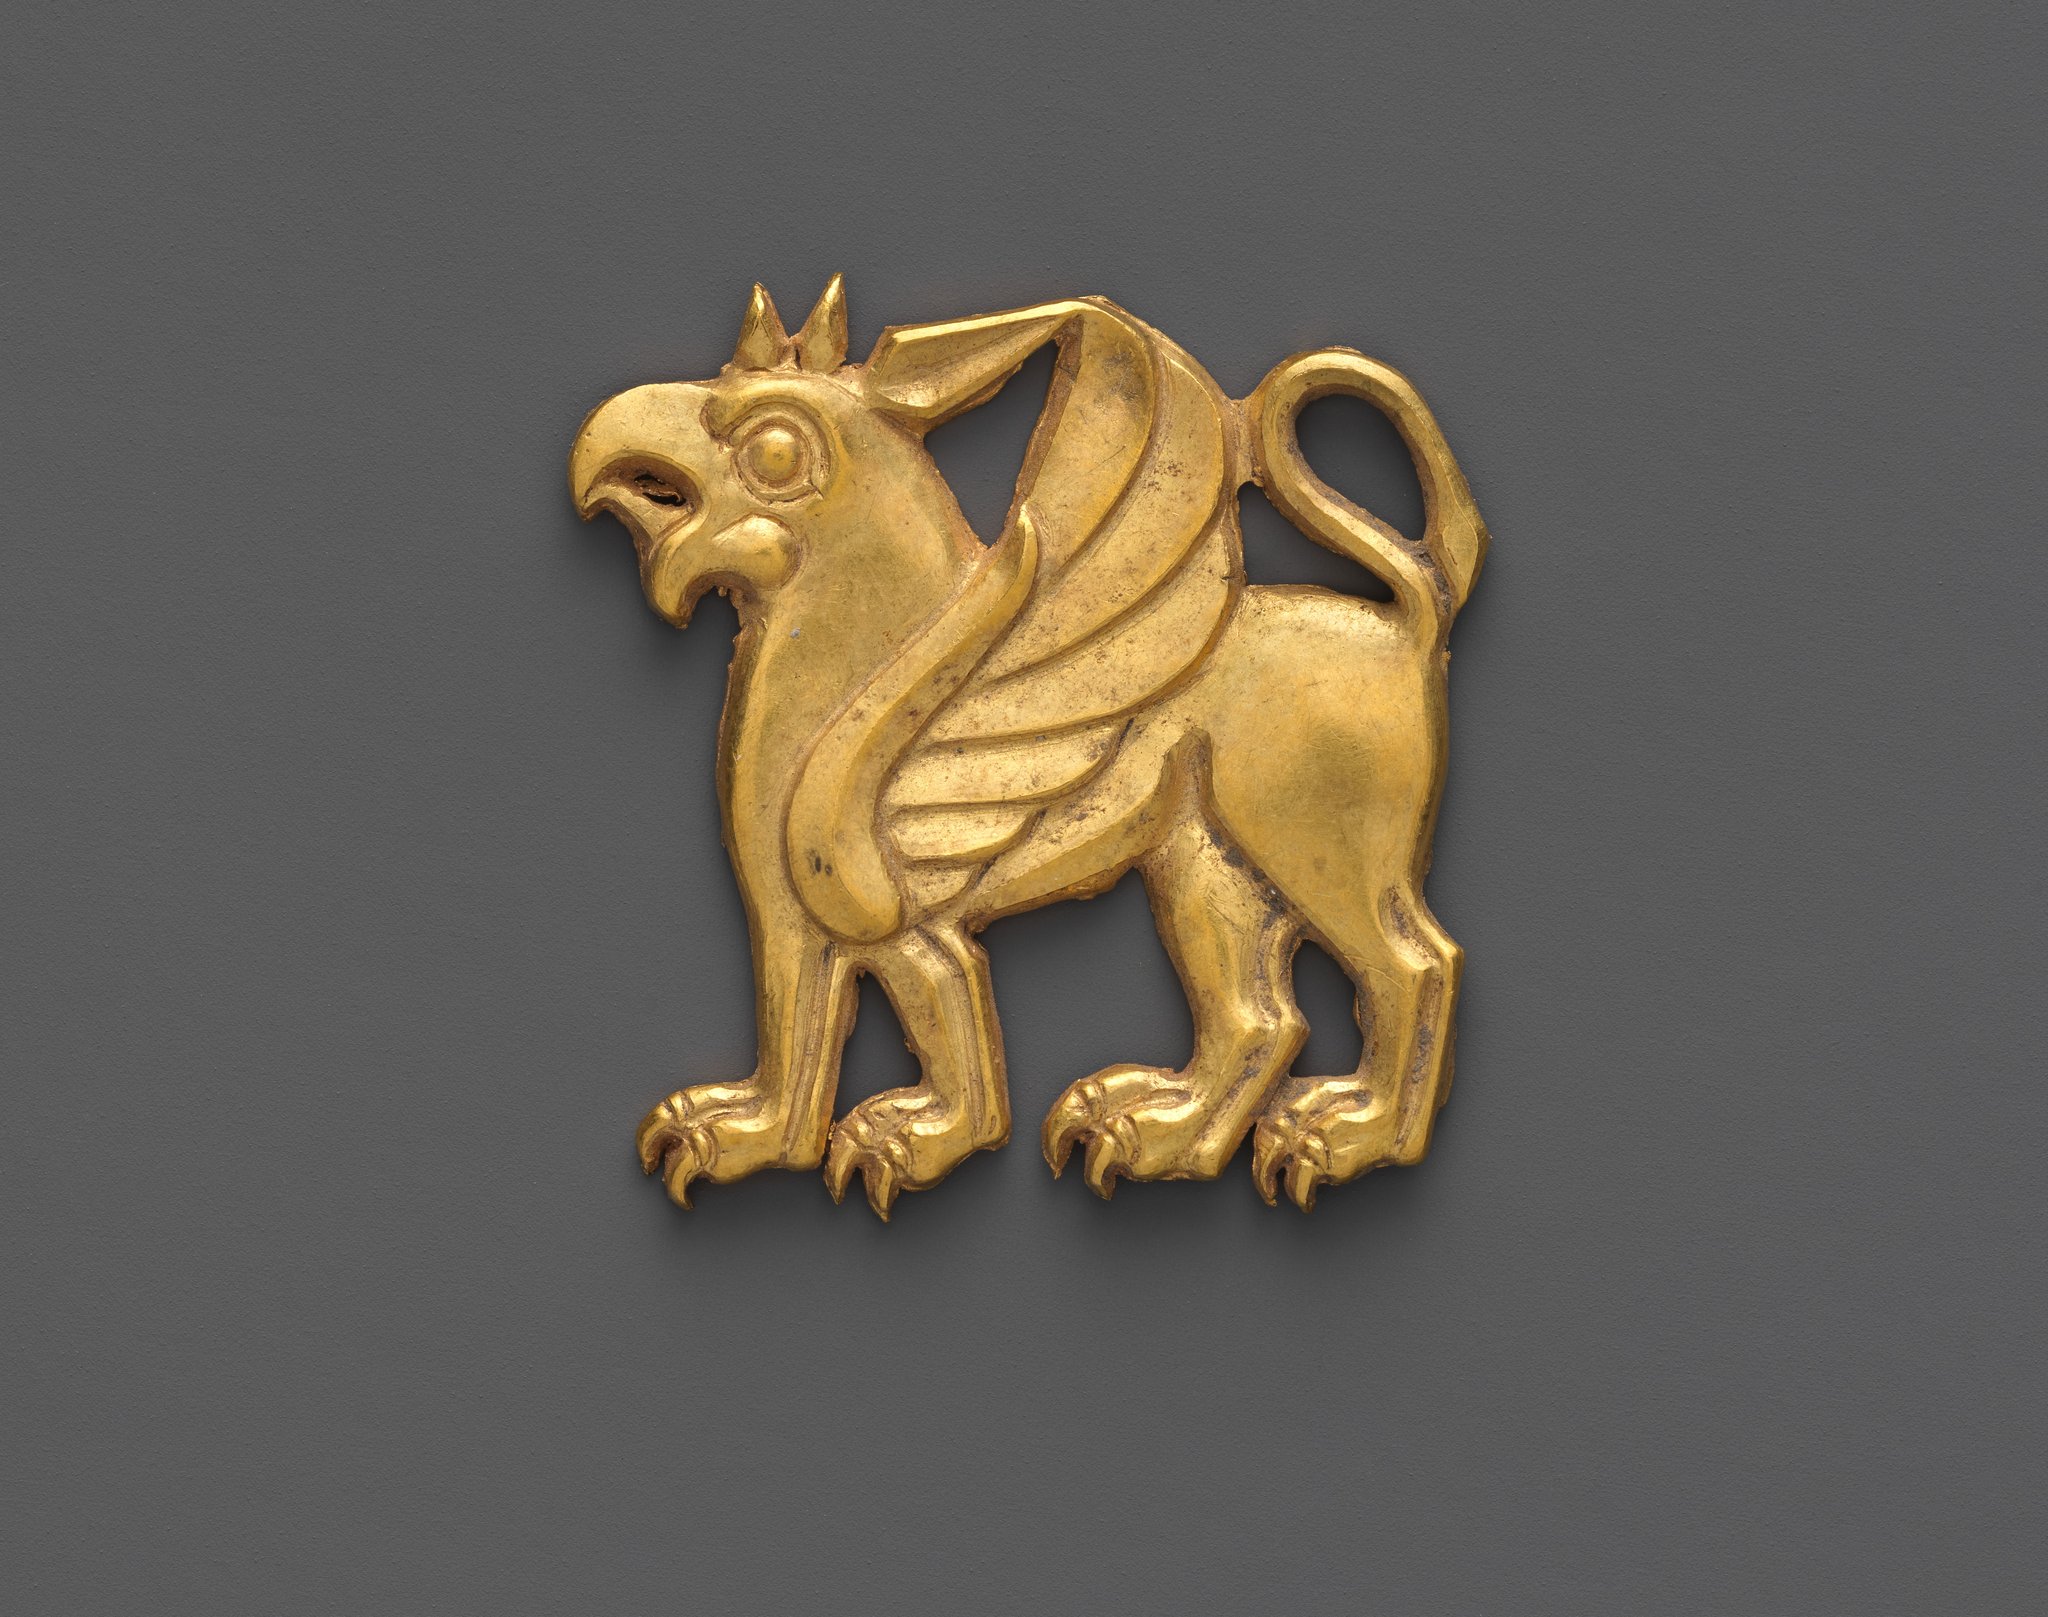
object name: dress ornament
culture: scythian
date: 500-401 BCE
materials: gold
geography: northern black sea region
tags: griffins